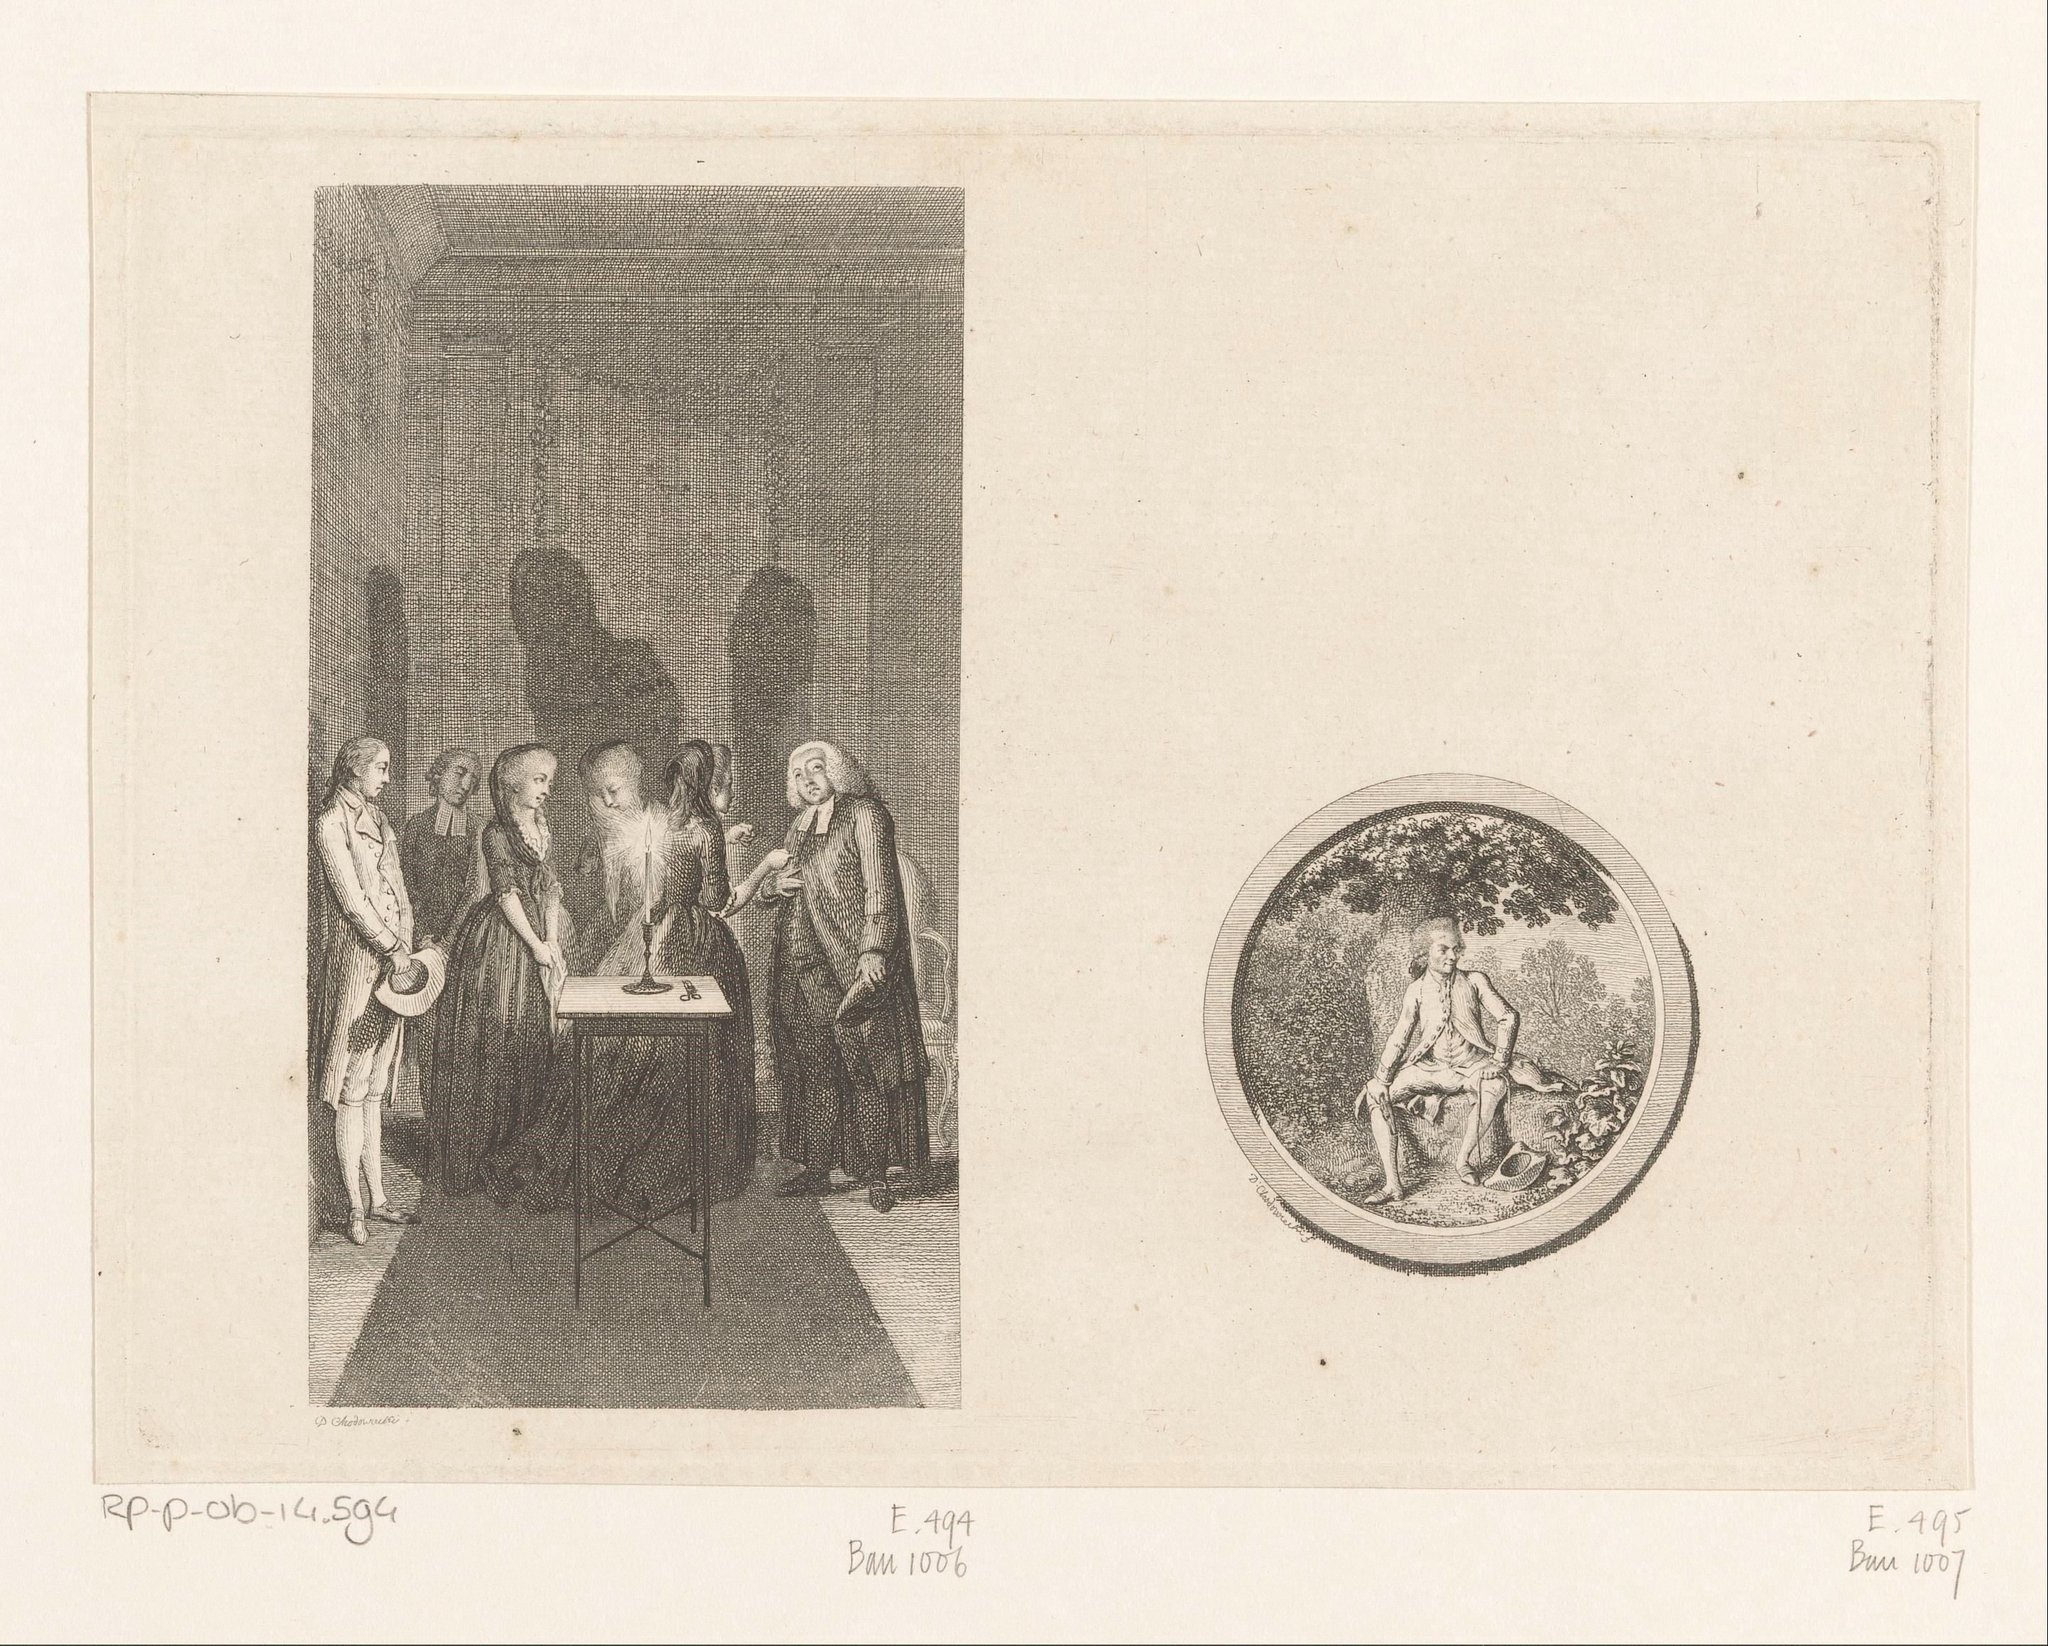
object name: print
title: Twee voorstellingen uit Salzmann's Carl von Carlsberg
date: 1783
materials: paper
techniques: etching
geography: berlin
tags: sitting figure, garland, wreath, literature, mourning customs, candle, interior of the house, firearms (with name), tools, aids, implements ~ crafts and industries: rope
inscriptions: collector's mark: Lugt 2228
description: In de linker scène treuren Carl von Carlsberg en gevolg om de dood van de broer van diaken Rollow. Rechts een titelvignet van de man die zelfmoord probeerde te plegen, maar door Carl en Rollow werd gered.